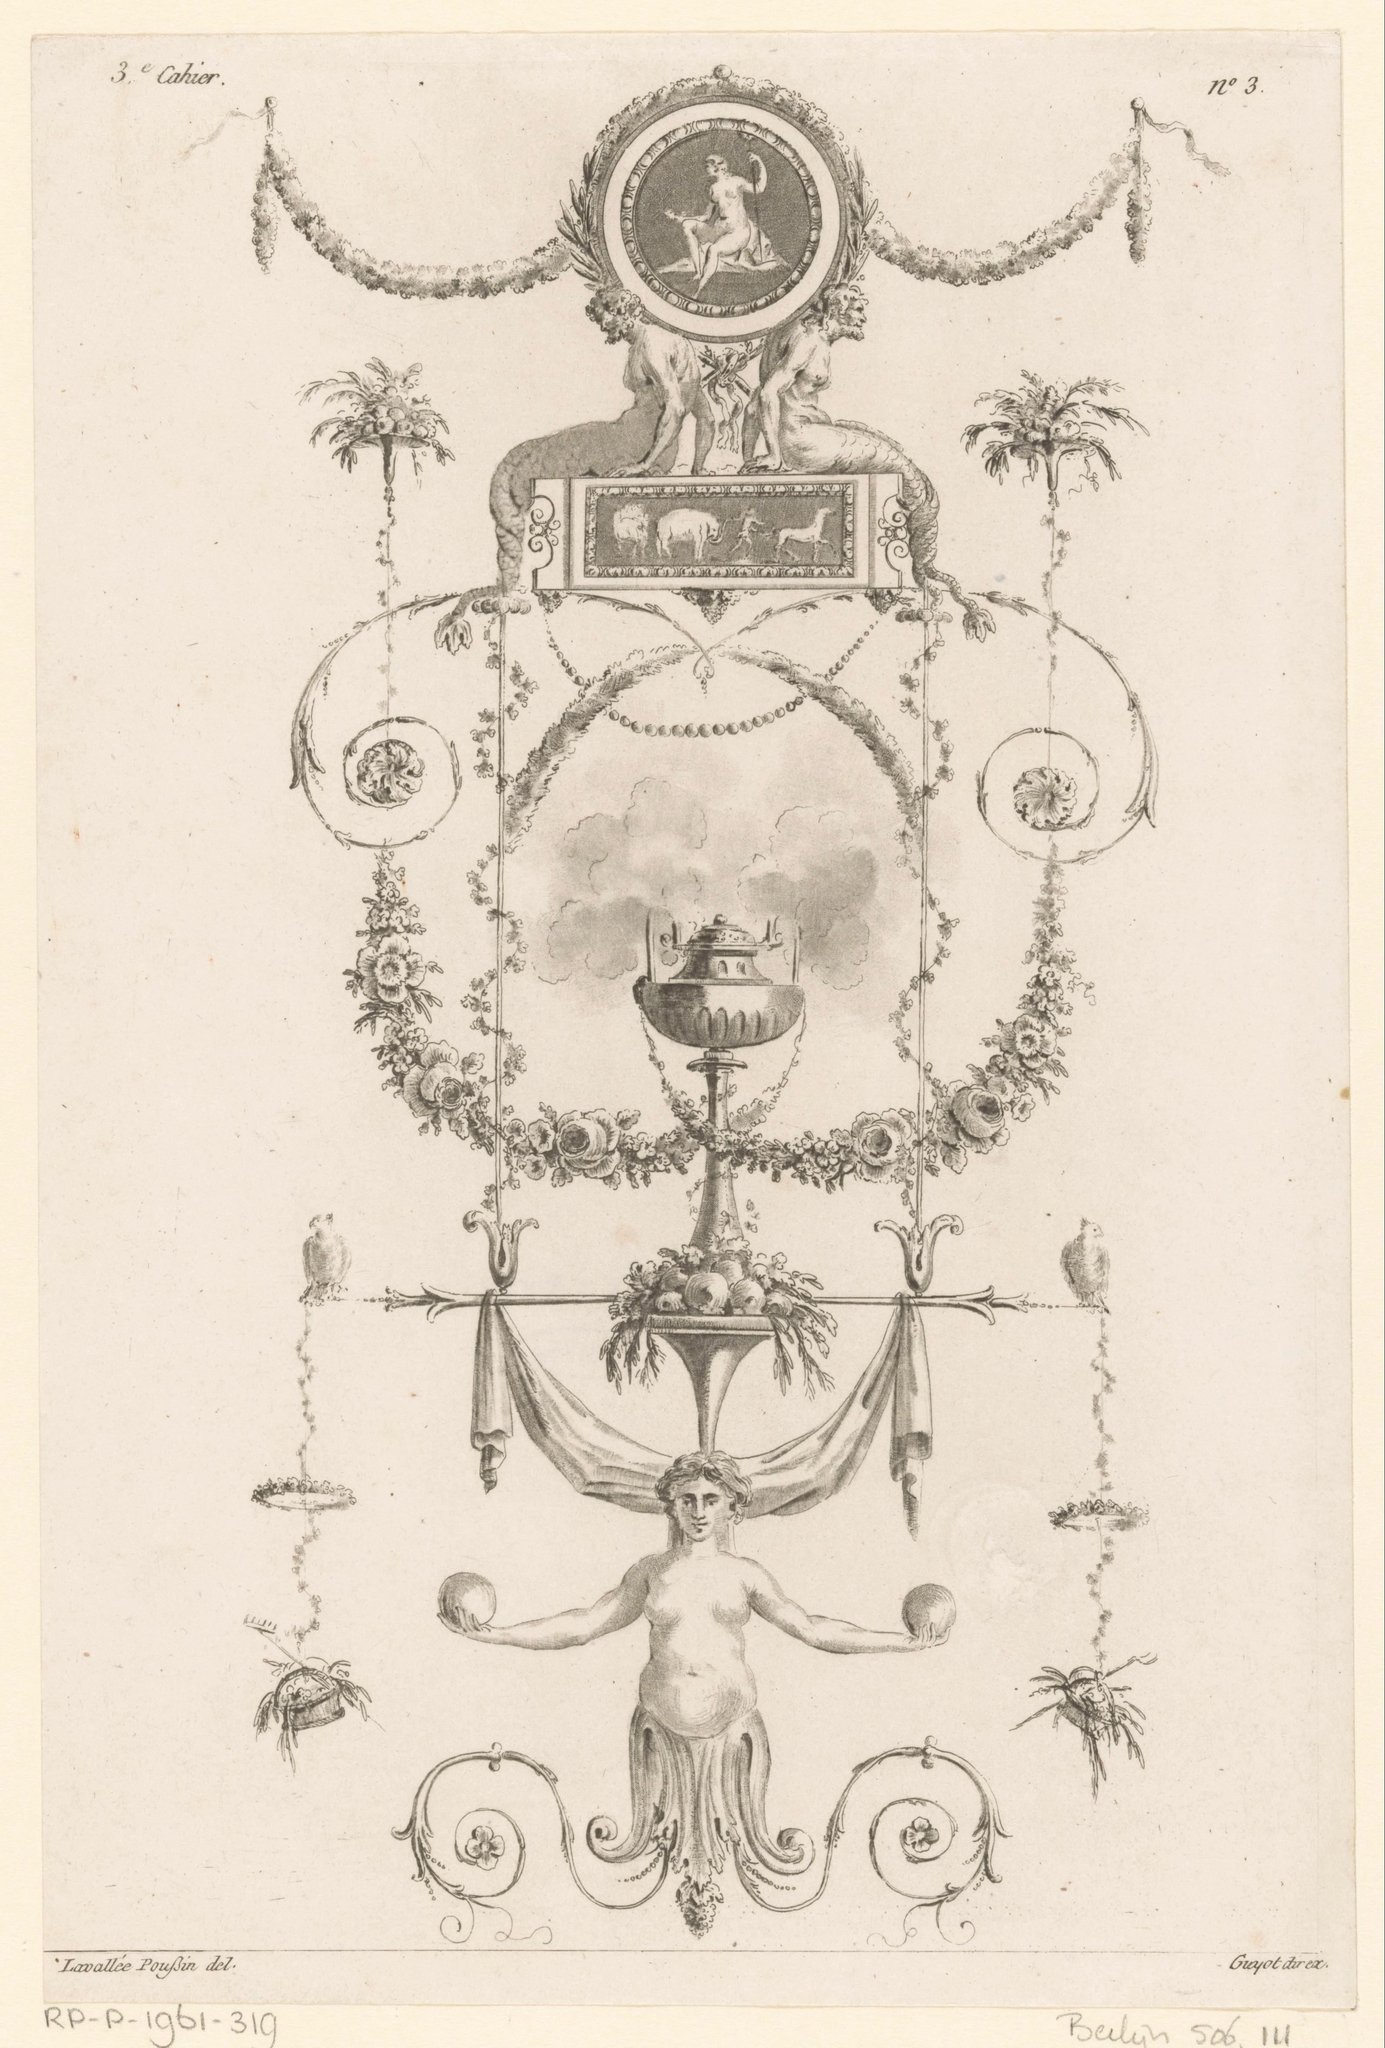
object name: ornament print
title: Arabesken met rookvat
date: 1810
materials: paper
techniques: aquatint, etching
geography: paris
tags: ornament ~ arabesque, incense-burner ~ scents, perfumes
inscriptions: collector's mark: Lugt 2228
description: Een rookvat omringd door guirlandes en arabesken. Aan de onderzijde een vrouwelijk halffiguur met bollen in haar hand. Aan de bovenzijde zitten twee meermannen onder een rond medaillon met een naakte vrouw.